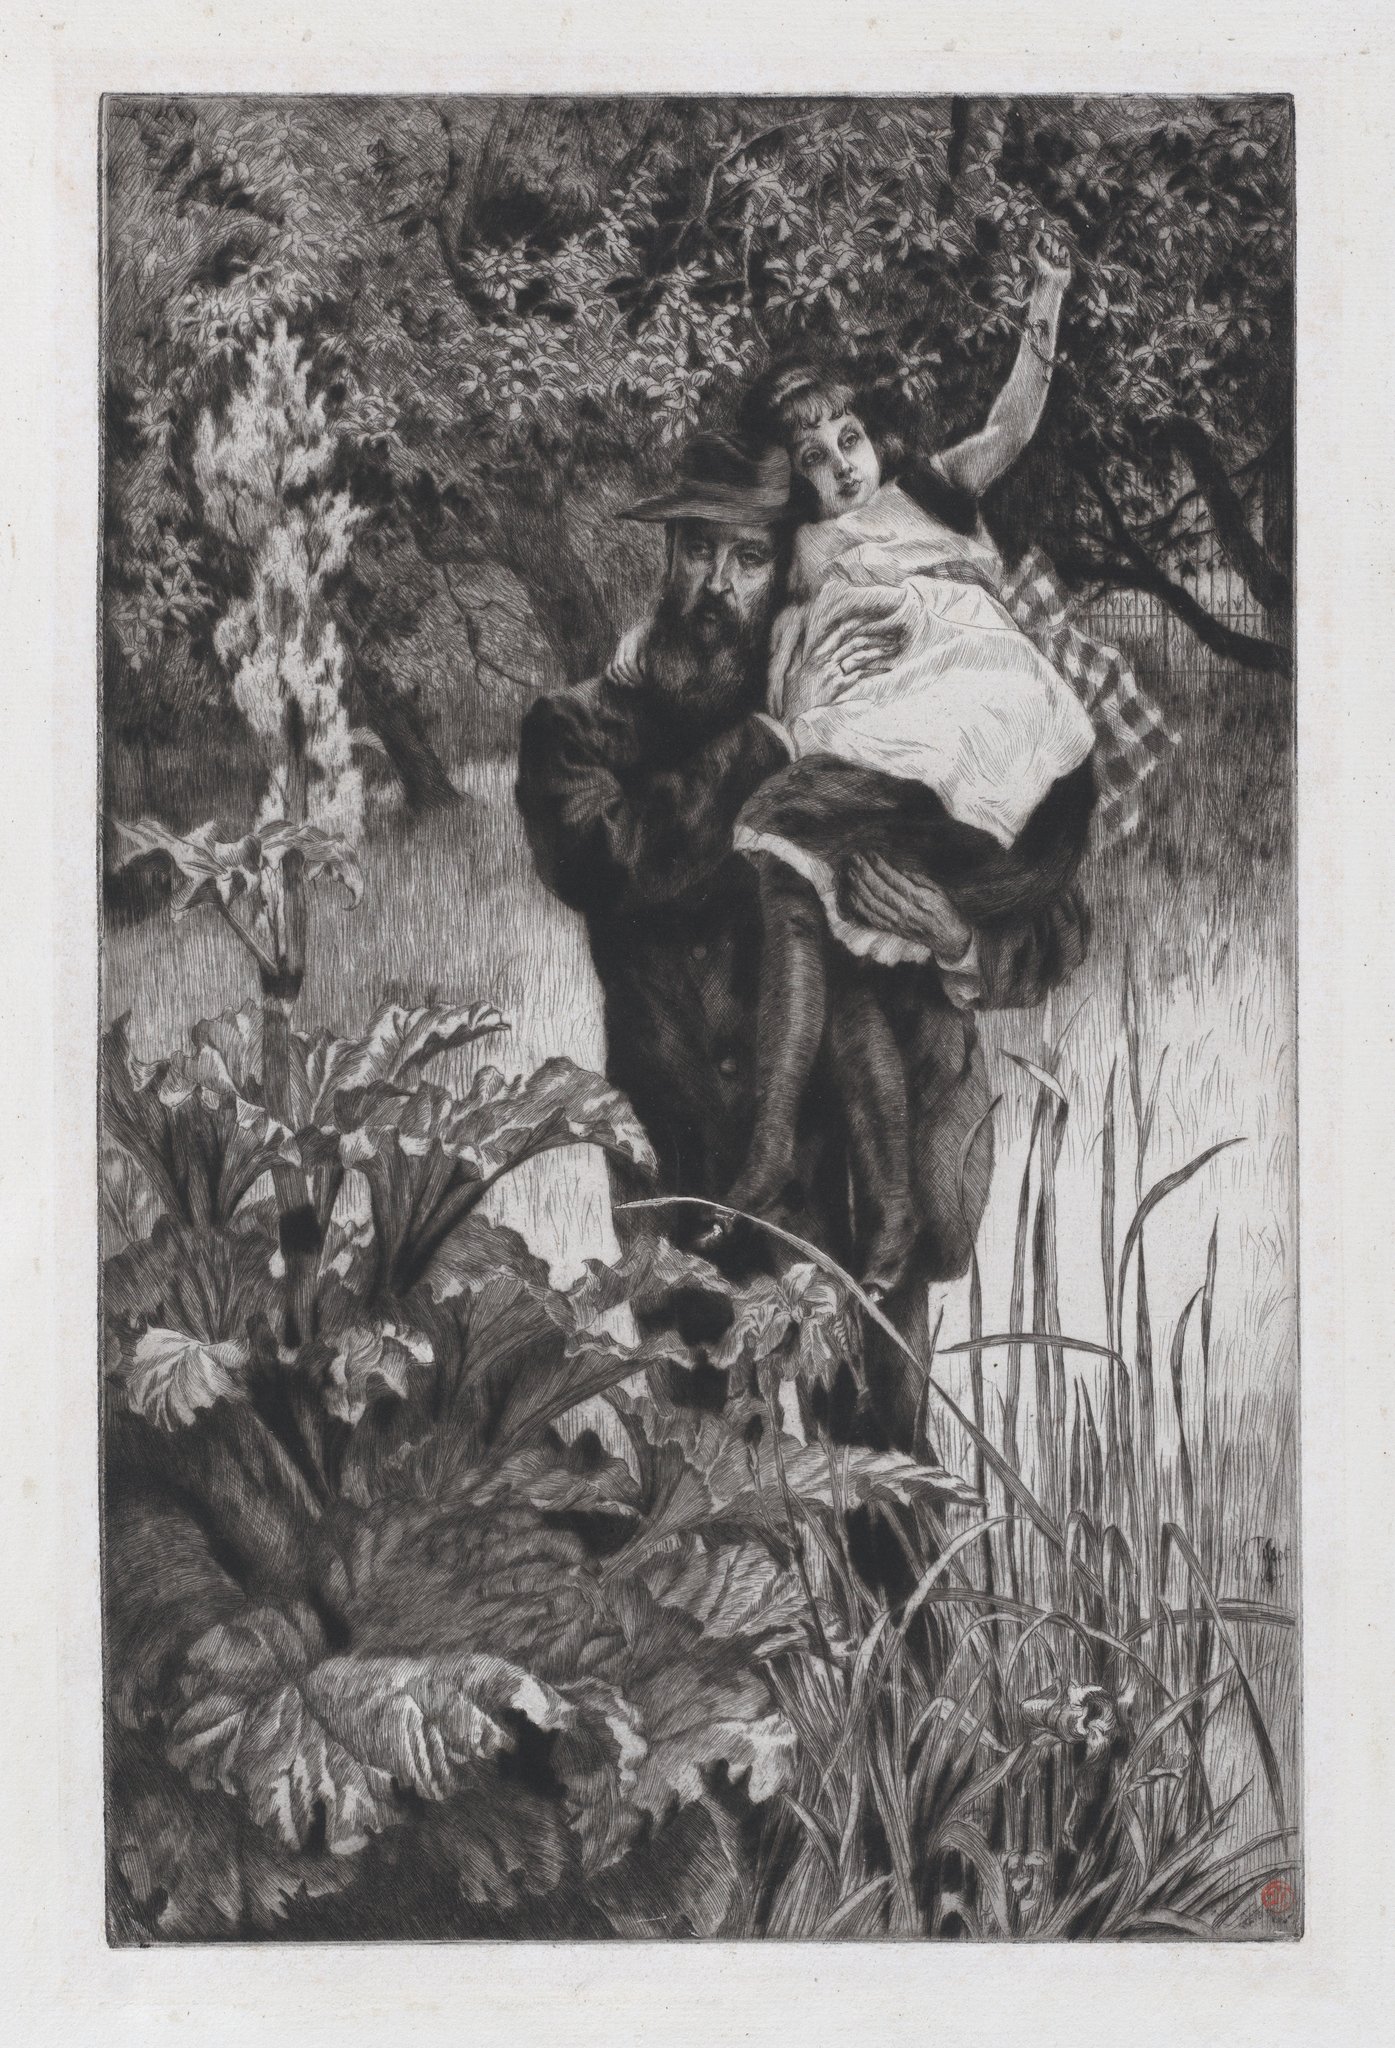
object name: print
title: The Widower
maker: james tissot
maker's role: artist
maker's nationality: french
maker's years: 1836-1902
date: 1877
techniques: drypoint, etching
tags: girls,men,fathers